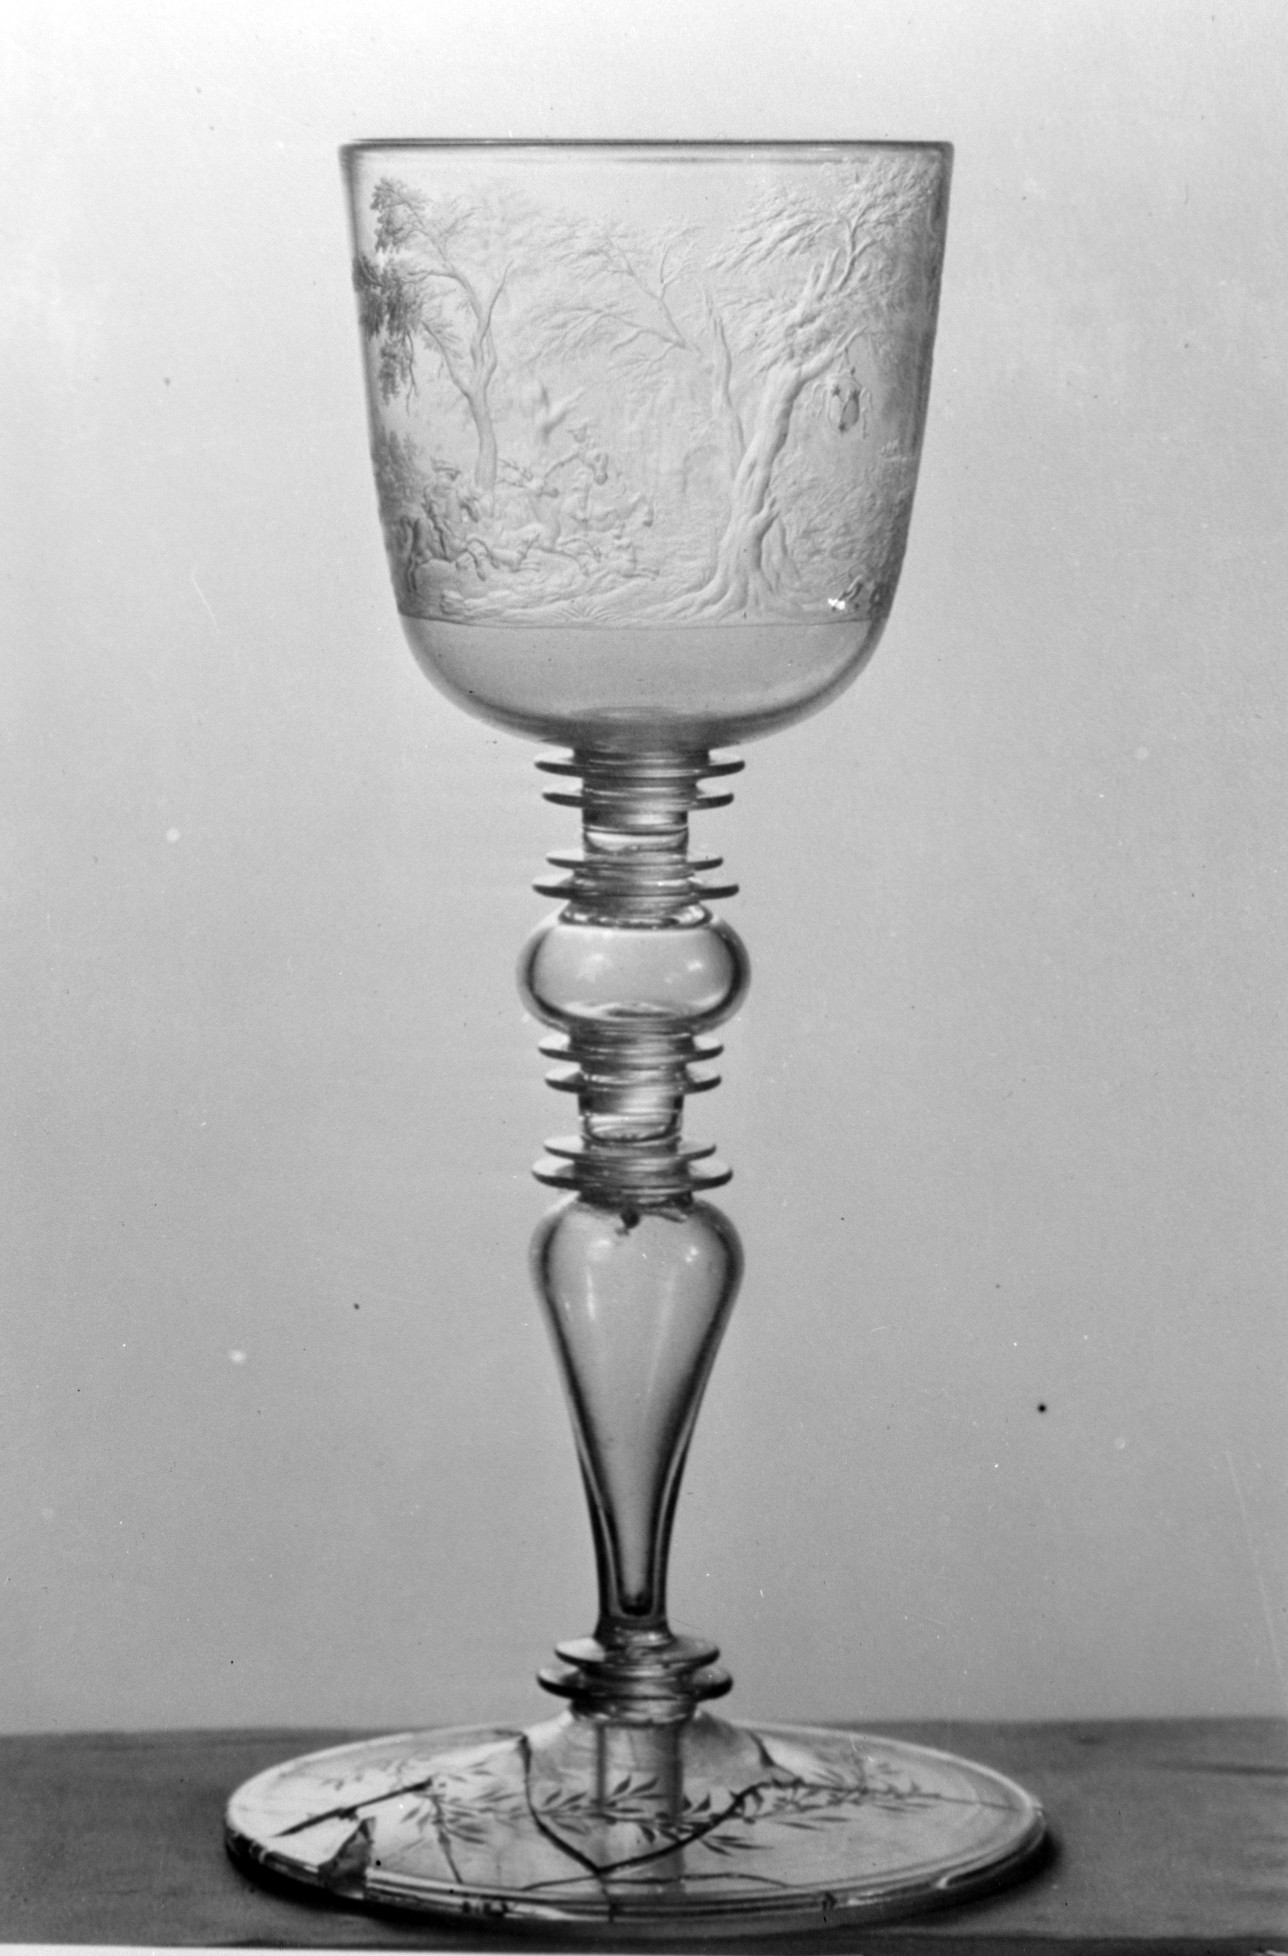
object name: standing cup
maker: georg friedrich killinger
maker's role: engraver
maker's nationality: german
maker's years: 1626-1726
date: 1701-1733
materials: glass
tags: trees